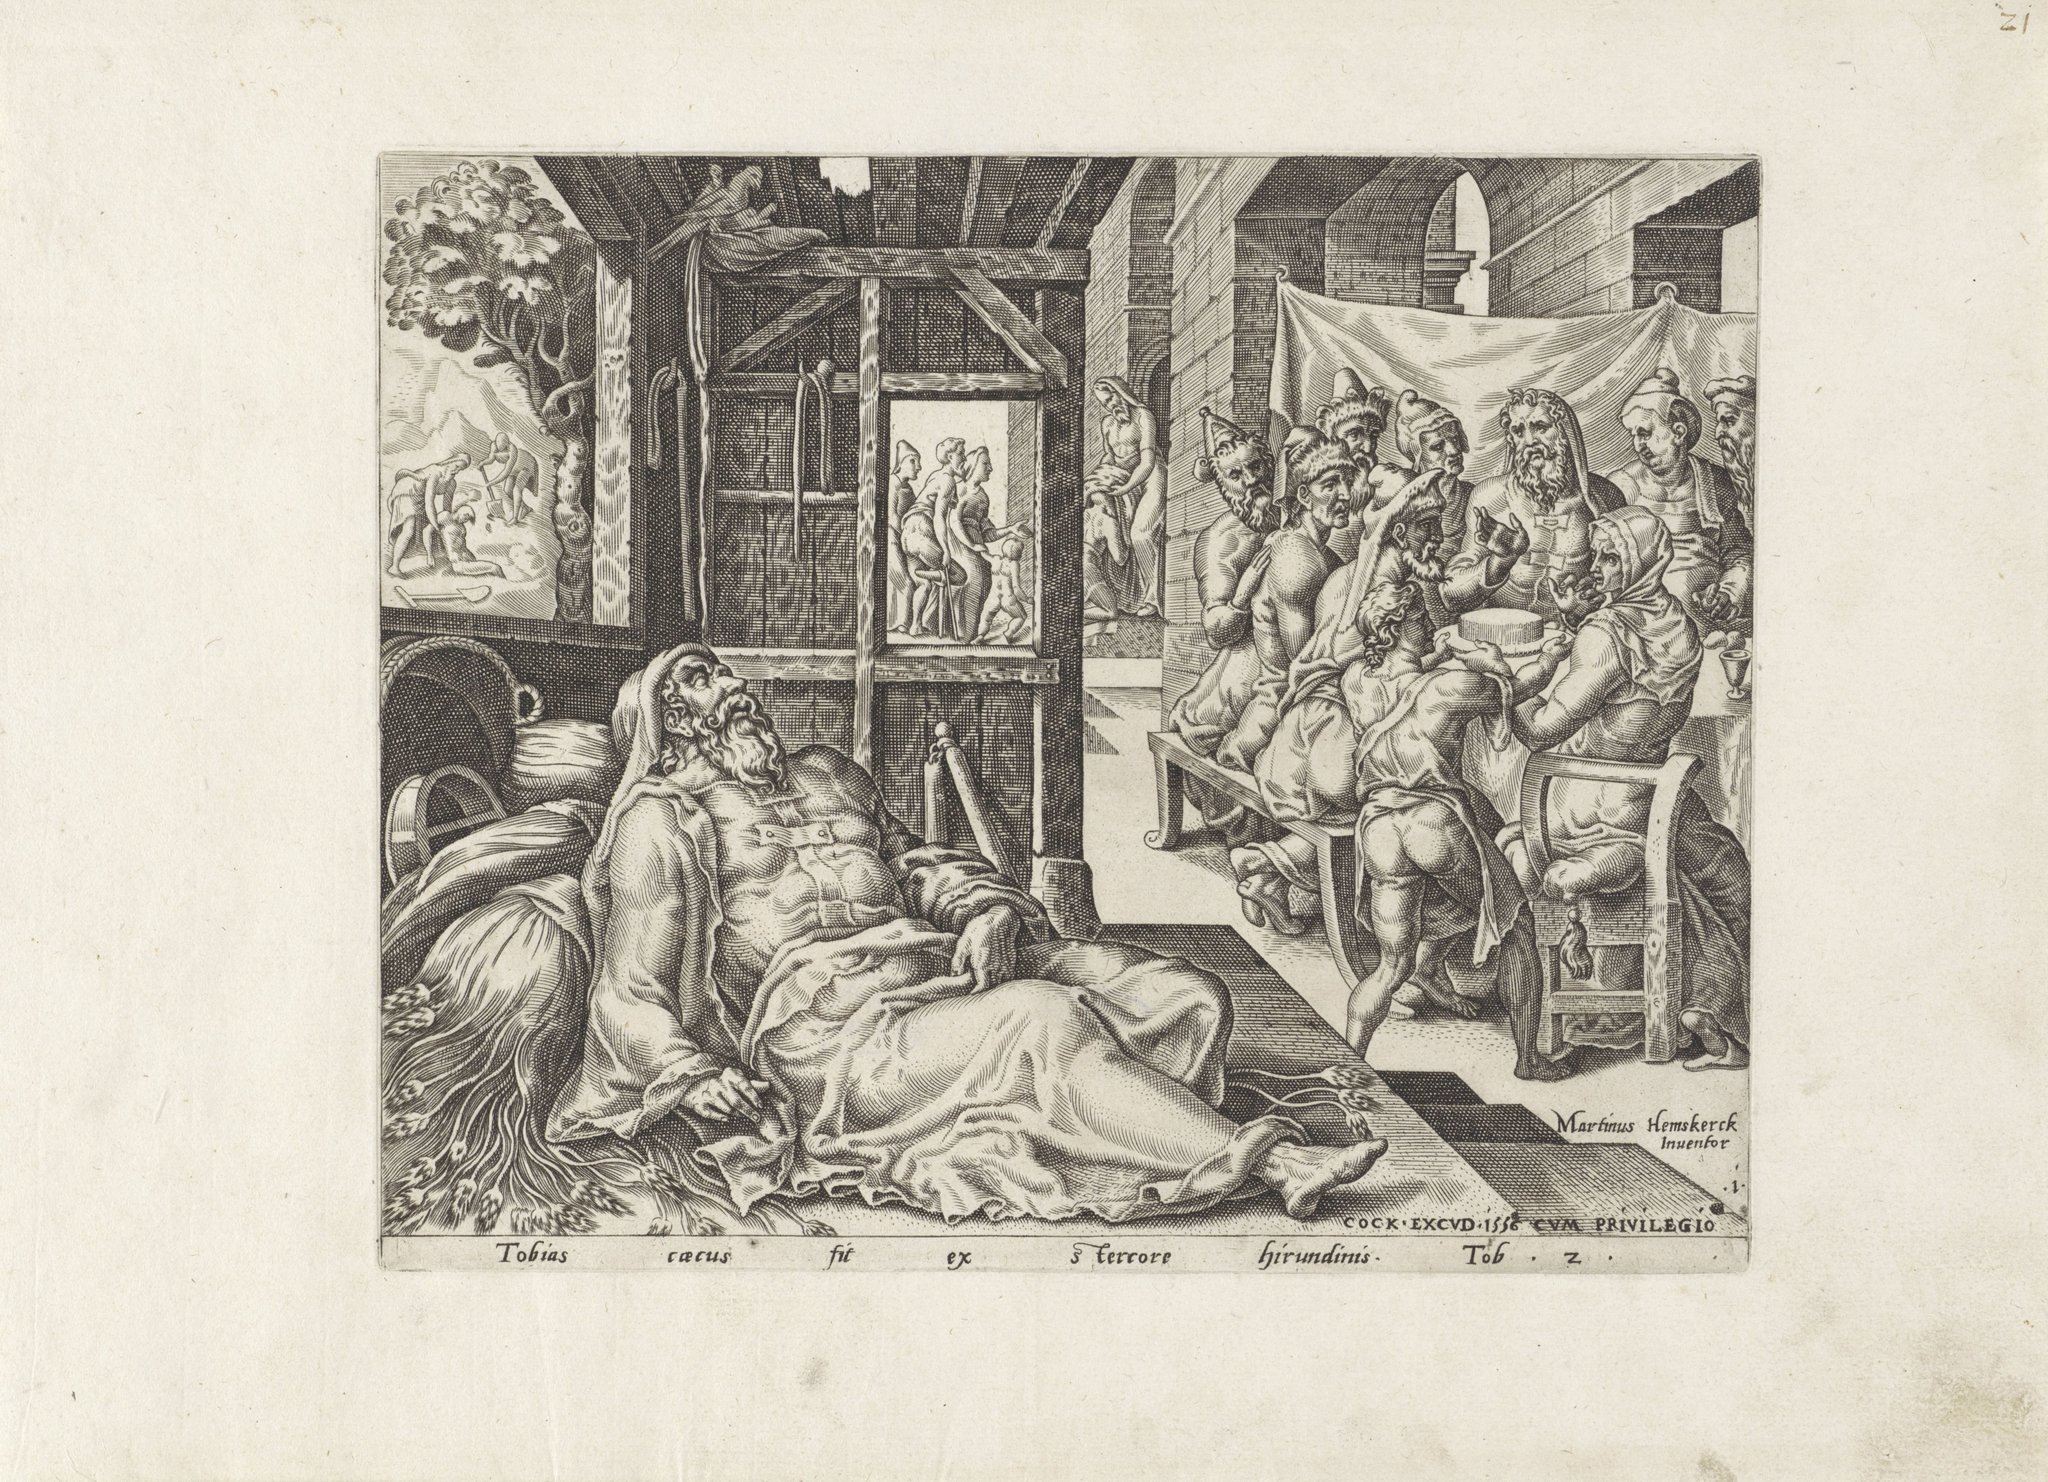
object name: print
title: Verhaal van Tobias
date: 1556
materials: paper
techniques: engraving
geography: antwerp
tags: a bird dropping falls in tobit's eyes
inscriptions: number: ‘21’, collector's mark: Lugt 2228, collector's mark: Lugt 2760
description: Links op de achtergrond begraaft Tobit het lichaam van de vermoorde man, die door Tobias op straat is gevonden. Na de begrafenis valt Tobit in slaap op enkele zakken graan. Eén van de vogels in het nest boven zijn hoofd laat zijn vogelpoep in Tobits ogen vallen, waardoor hij blind wordt. Midden achter geeft hij kleding aan de armen en rechts zit hij aan het feestmaal. Onderaan in de marge een éénregelig onderschrift in het Latijn uit Tobit 2.